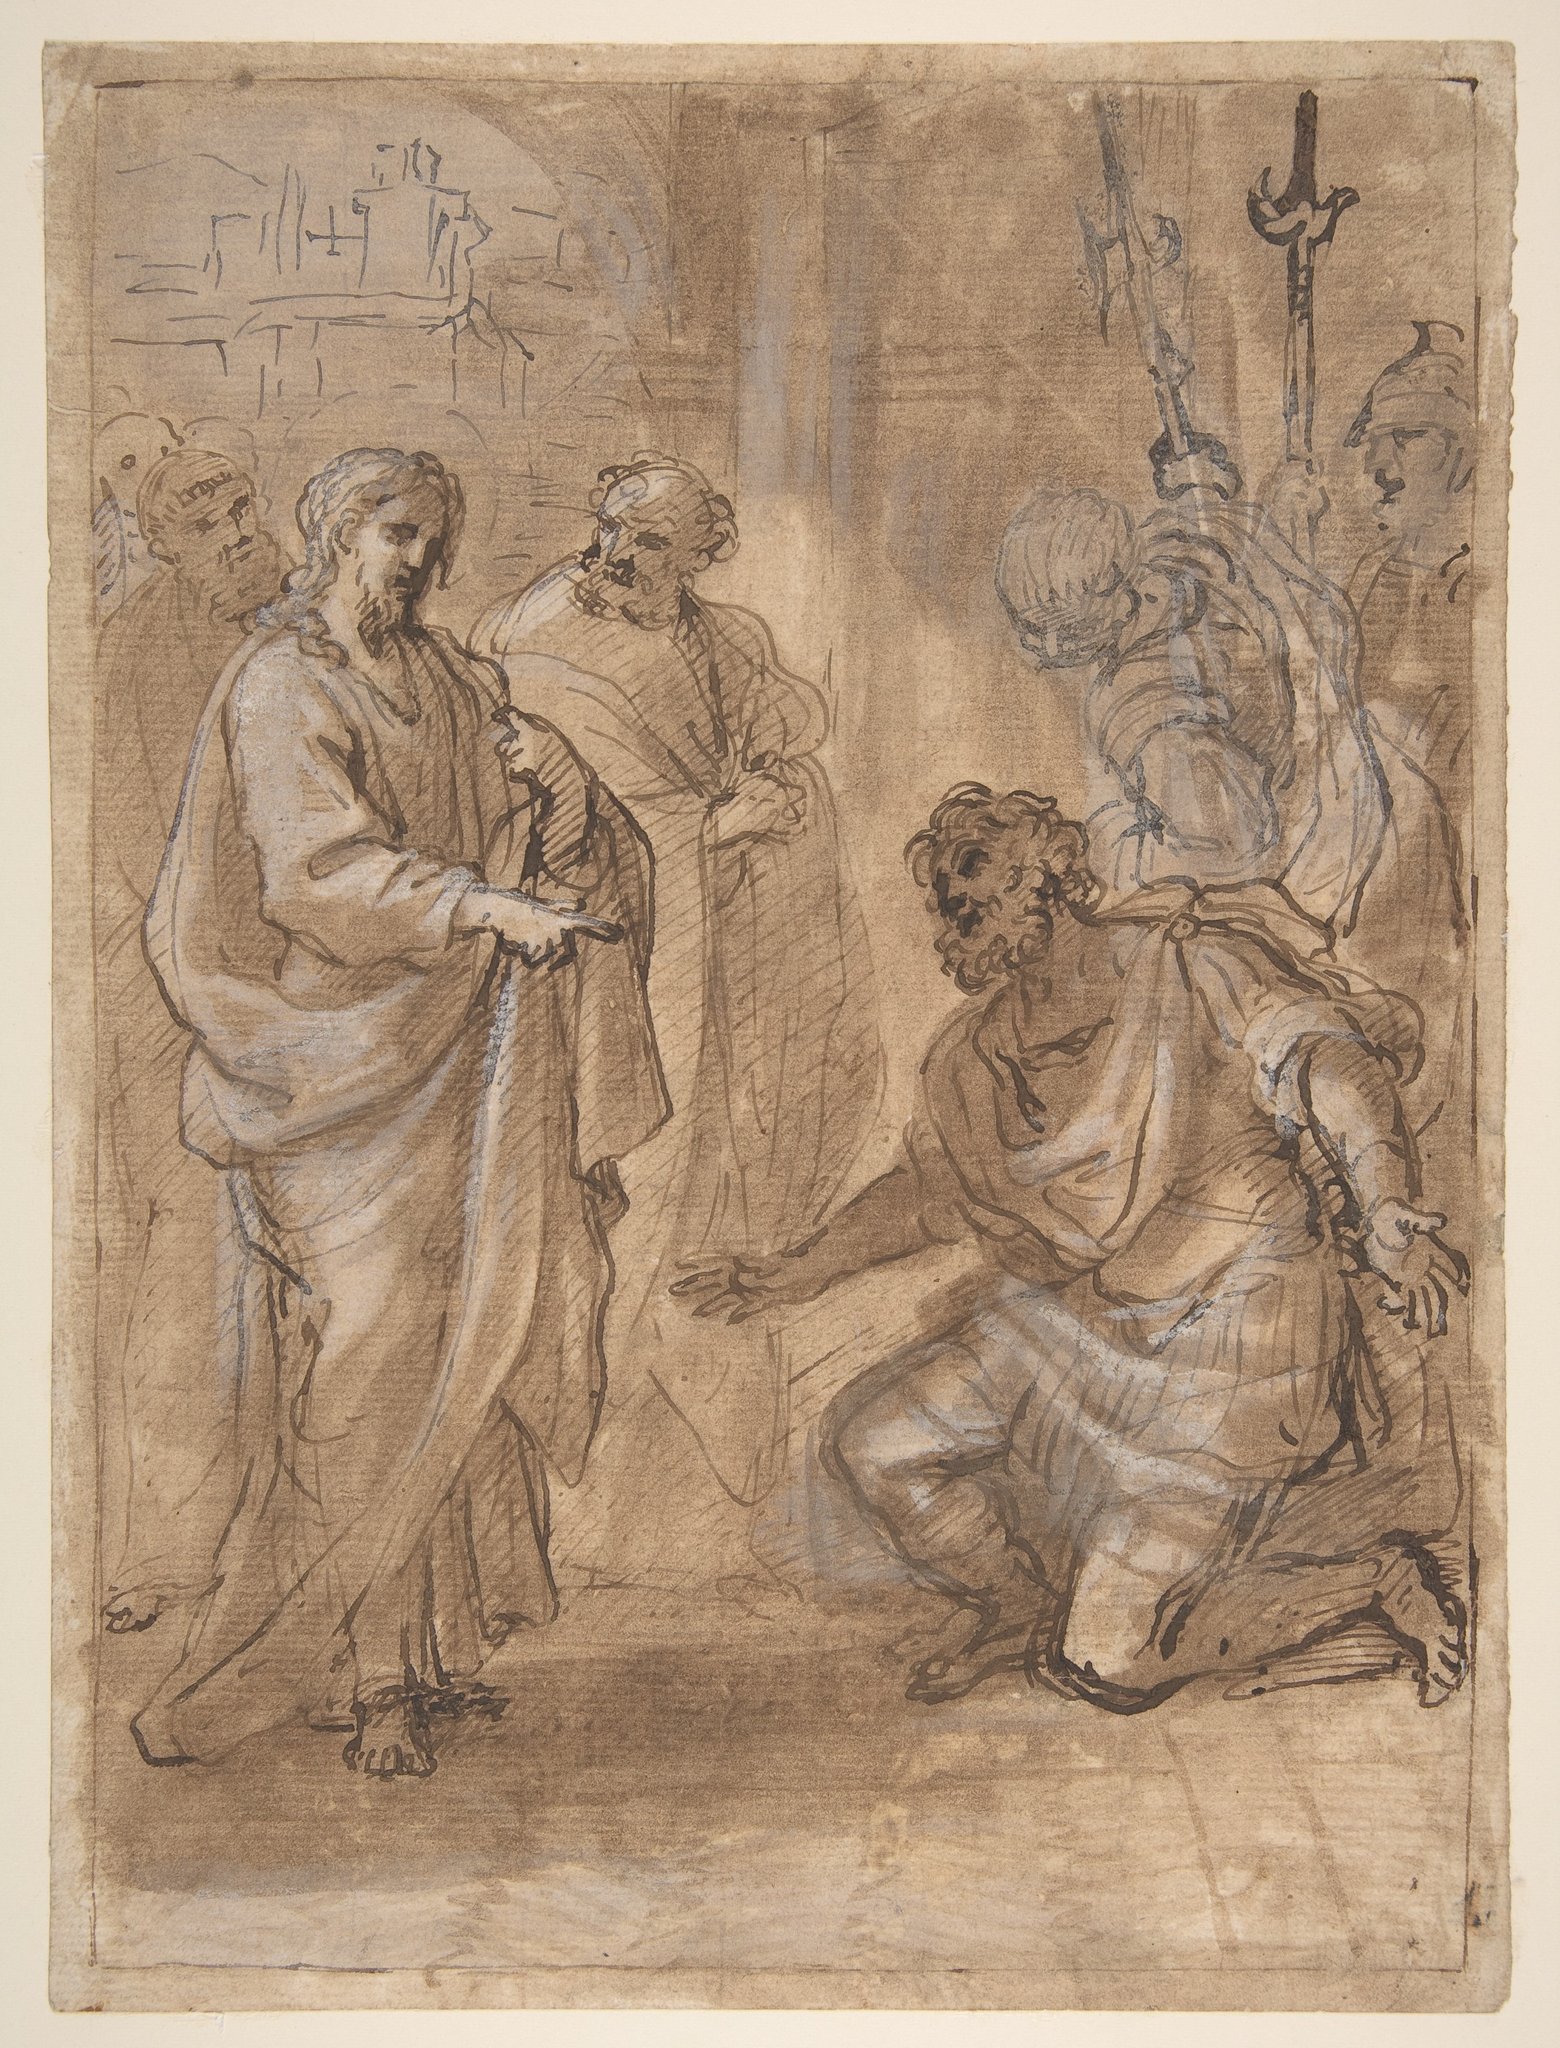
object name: drawing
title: Christ and the Centurion (recto); Figure Waving to Departing Ship (verso)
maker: giuseppe passeri (passari)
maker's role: artist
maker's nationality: italian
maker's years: 1654-1714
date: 1665-1714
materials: gouache, ink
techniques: brush, highlighting, pen, wash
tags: weapons,men,christ